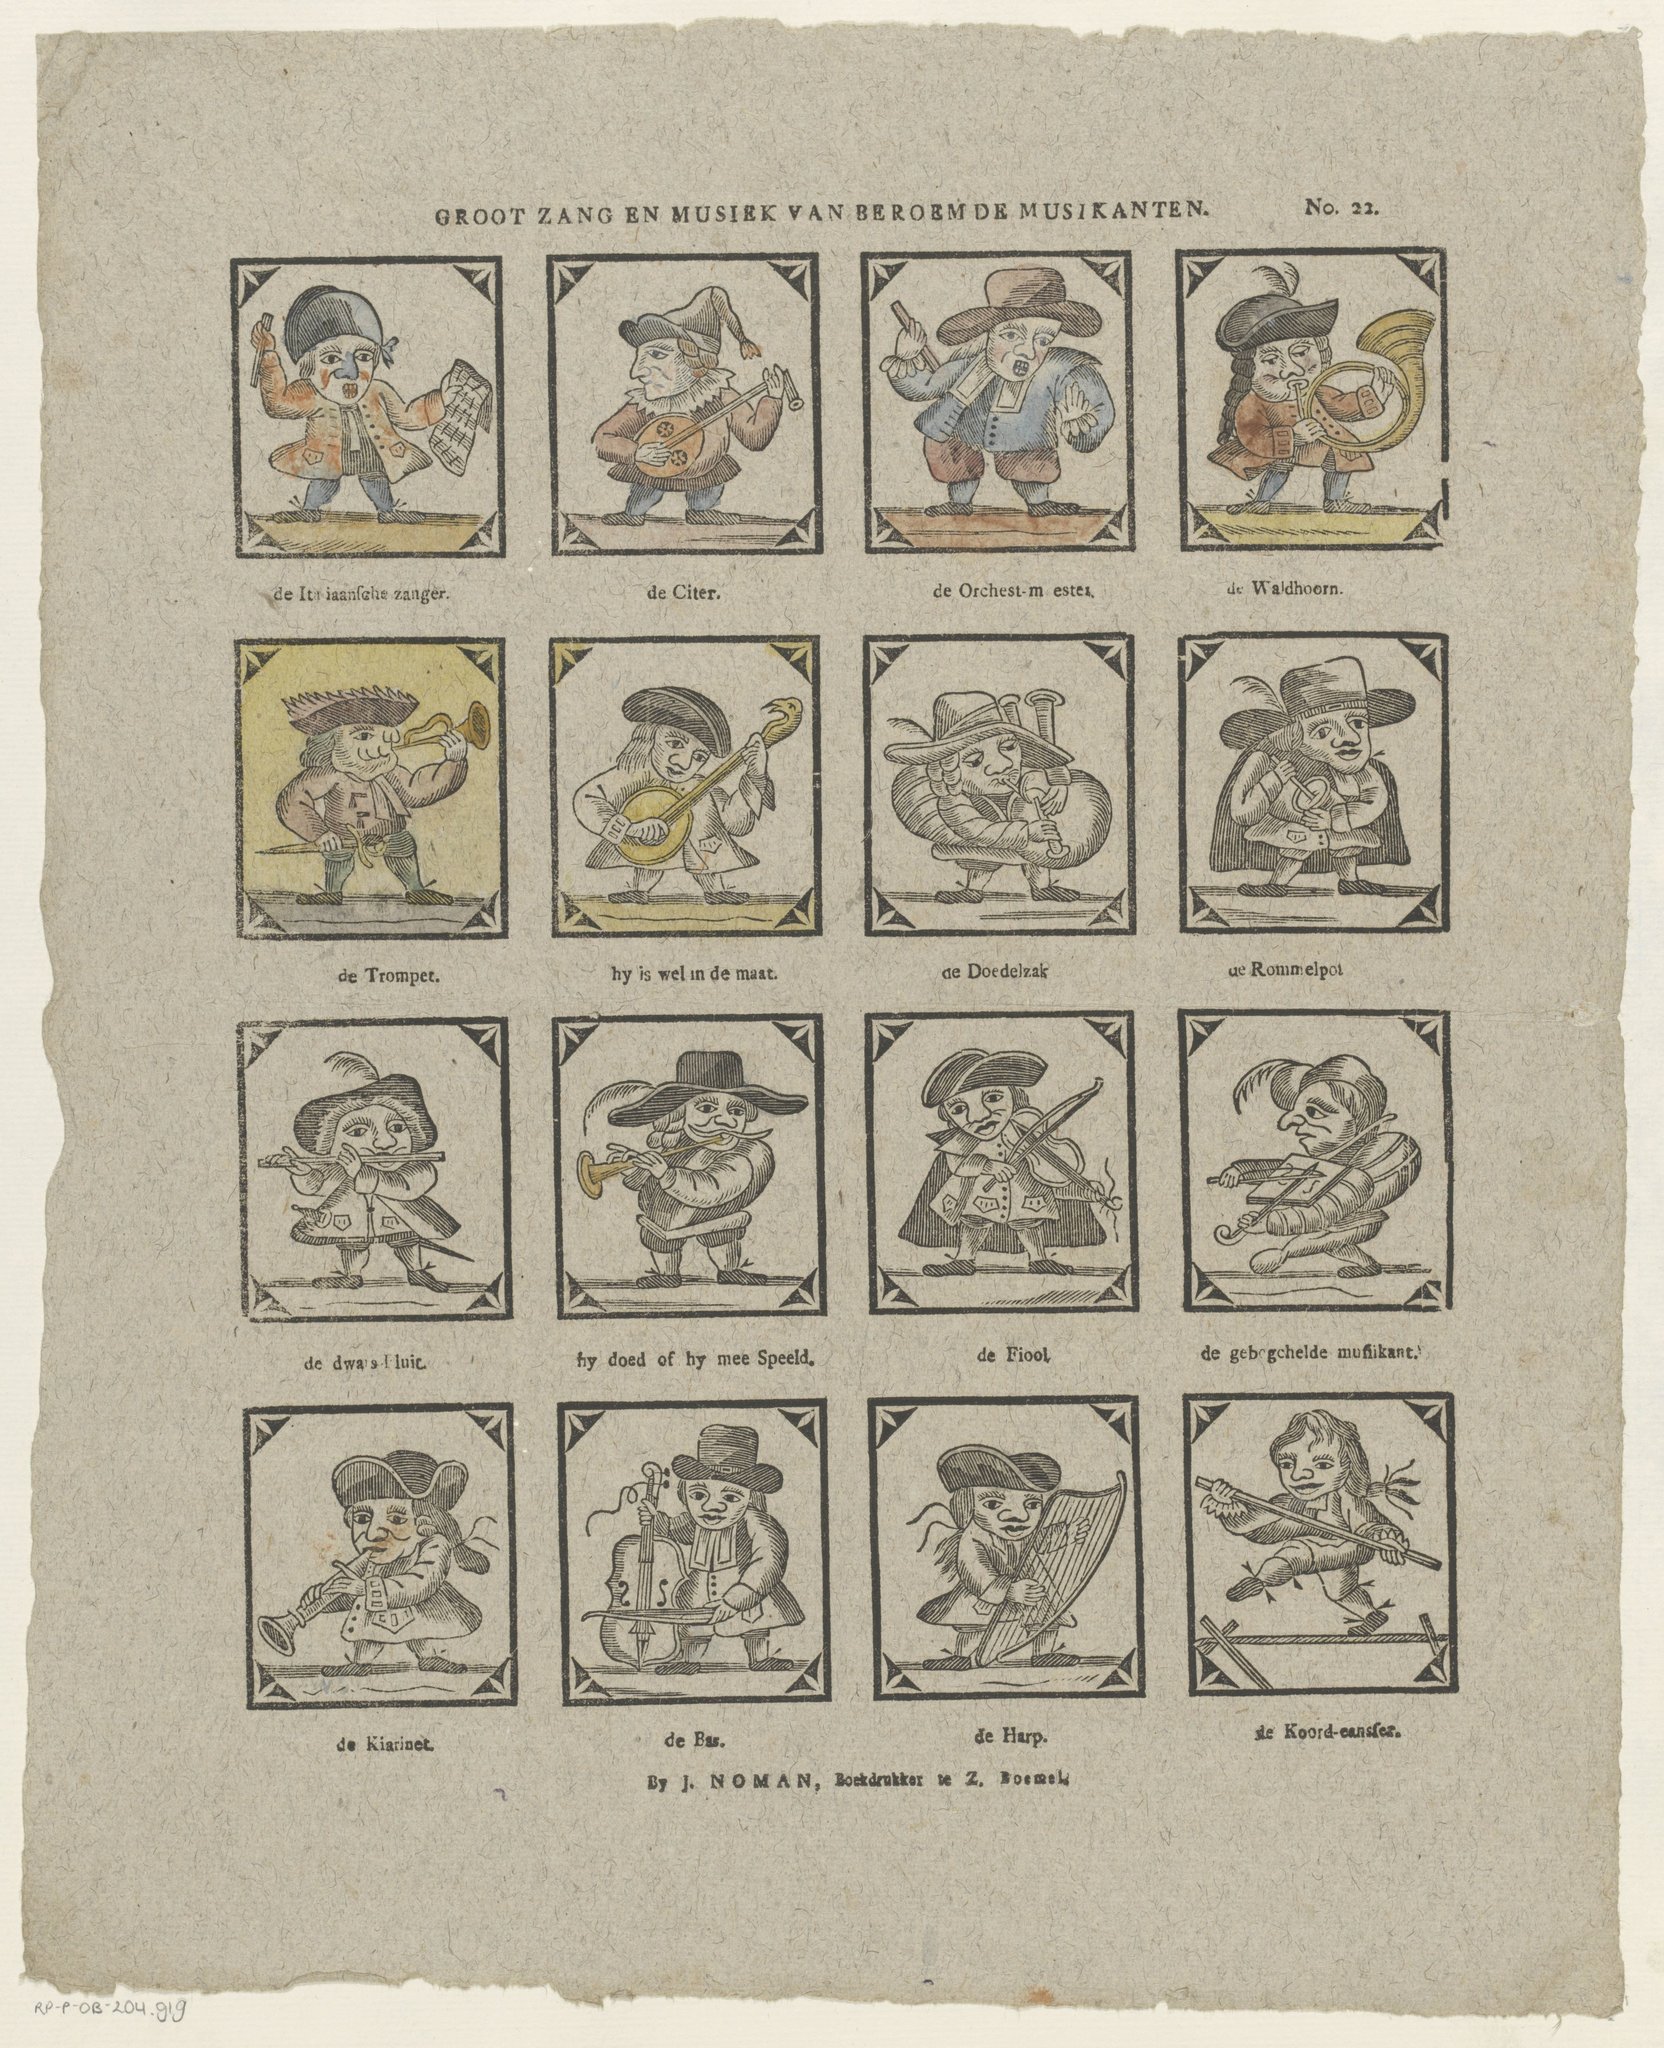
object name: popular print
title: Groot zang en musiek van beroemde musikanten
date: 1806-1830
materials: paper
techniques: colour, letterpress printing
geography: netherlands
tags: musical instruments; group of musical instruments, musician, ropery, rope-walk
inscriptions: collector's mark: Lugt 2760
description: Blad 16 voorstellingen van muzikanten met instrumenten, waaronder een citer, een hoorn, een doedelzak en een klarinet. Rechtsonder ook een koorddanser. Onder elke voorstelling een onderschrift. Genummerd rechtsboven: No. 22.